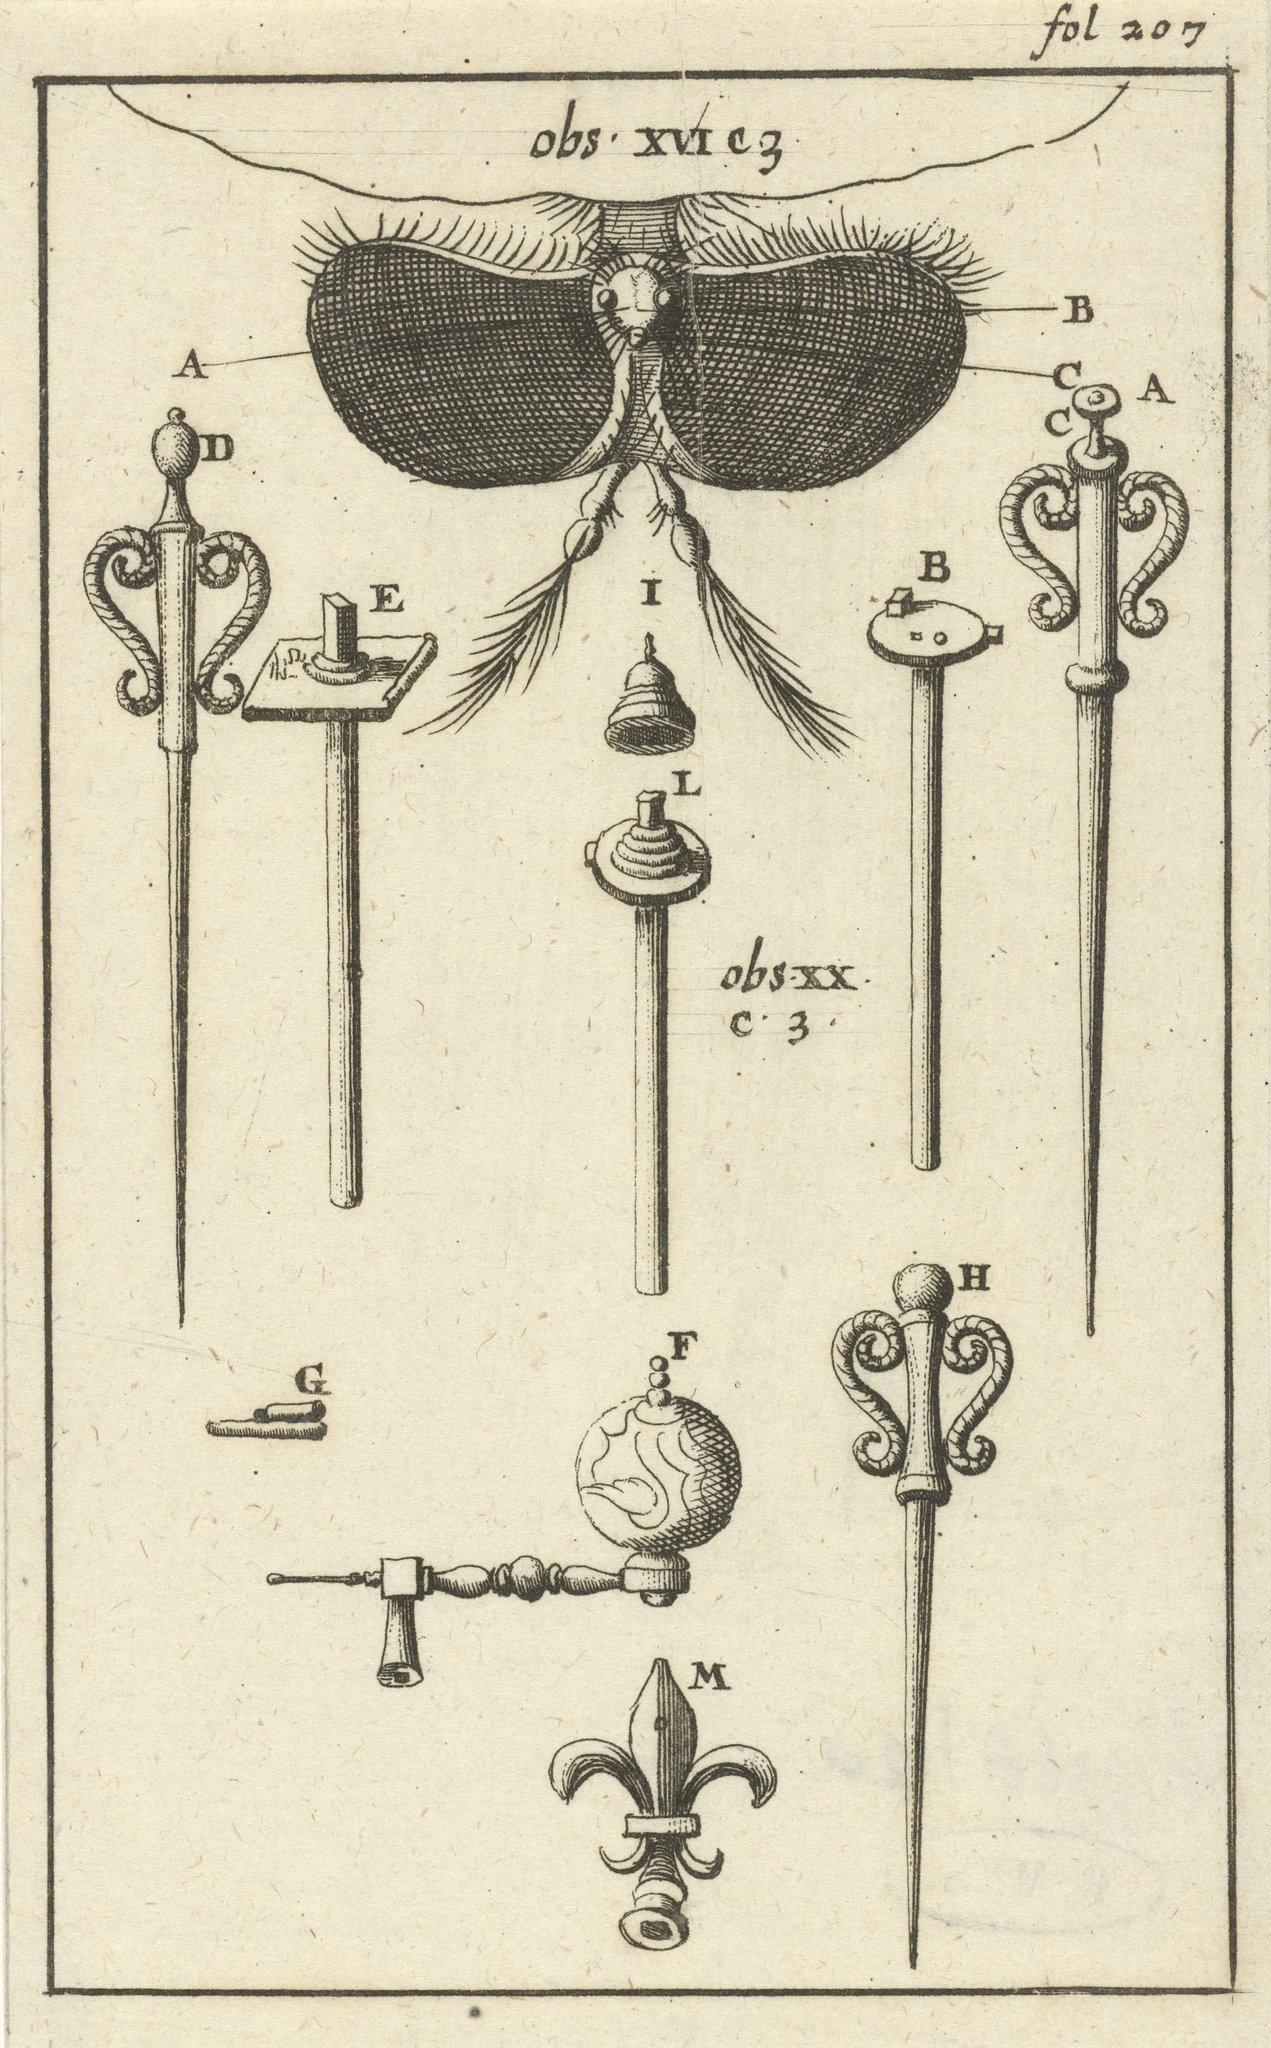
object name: print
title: Anatomische afbeelding VIII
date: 1680-1688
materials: paper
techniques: etching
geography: amsterdam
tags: biology, anatomical models (usually series of five figures)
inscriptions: collector's mark: Lugt 2228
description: Illustratie opgenomen in: Blankaart, Steven. Collectanea medico-physica, oft Hollands jaar-register der genees- en natuur-kundige aanmerkingen, 3 delen, dl. I, fol. 207. Amsterdam: Jan Claesz ten Hoorn, 1680-1688.